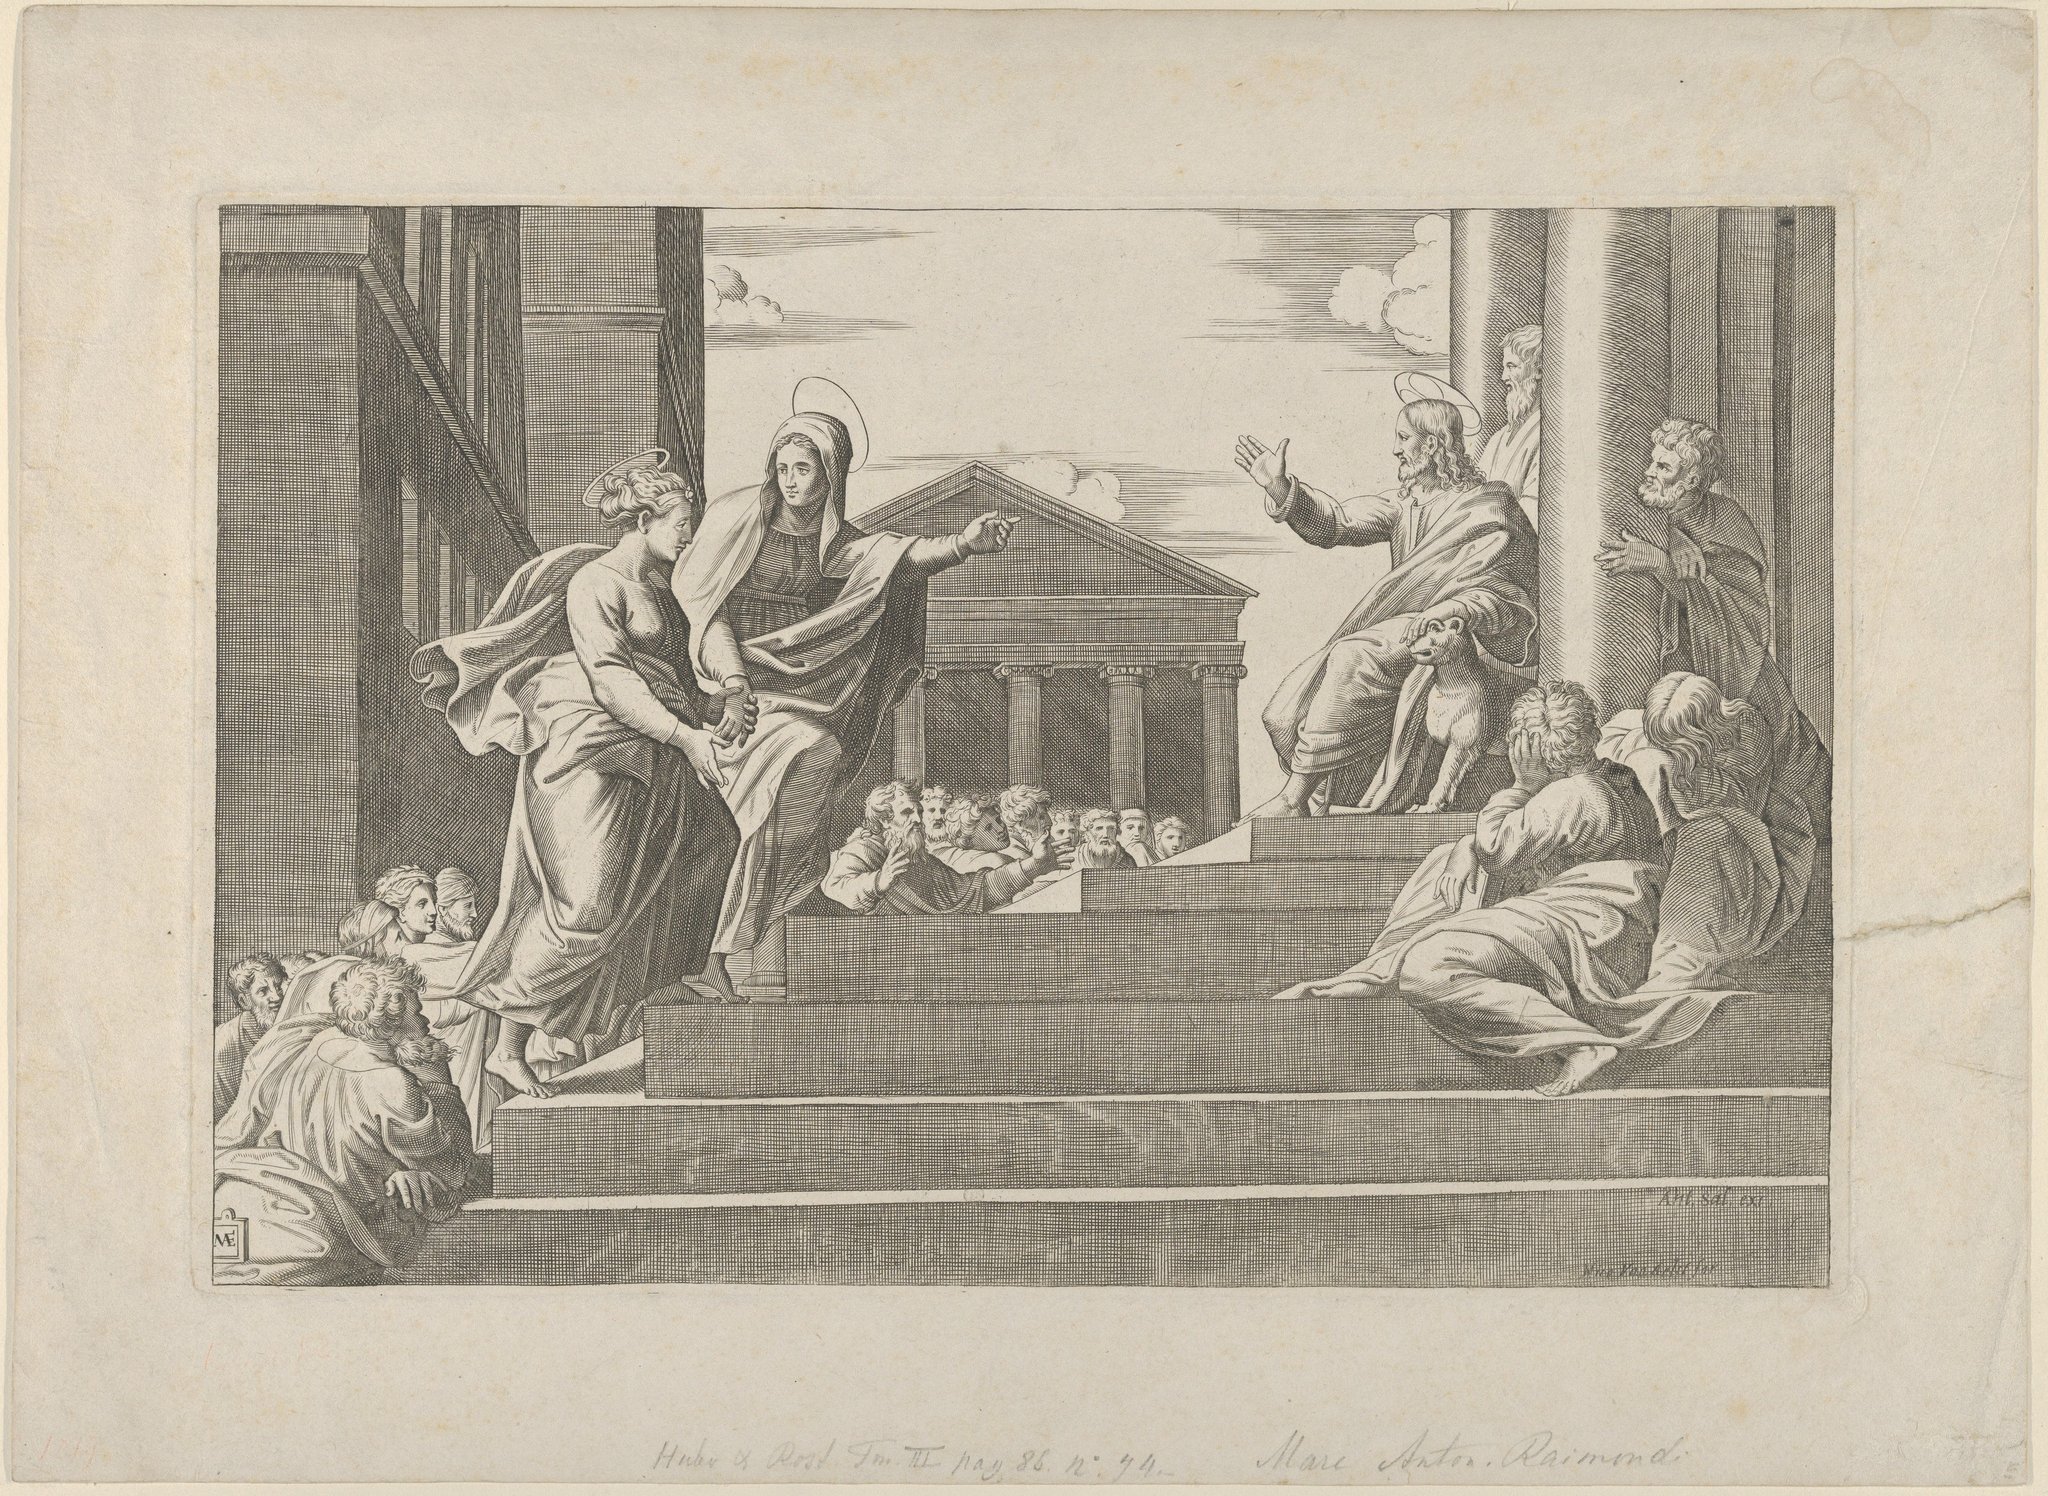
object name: print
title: Martha leading Mary Magdalene up a flight of stairs to Christ who is seated at right at the entrance to a temple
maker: anonymous, italian, 16th to early 17th century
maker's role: artist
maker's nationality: italian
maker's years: 1500-1640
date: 1530-1560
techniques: engraving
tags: temples,men,women,christ,mary magdalene